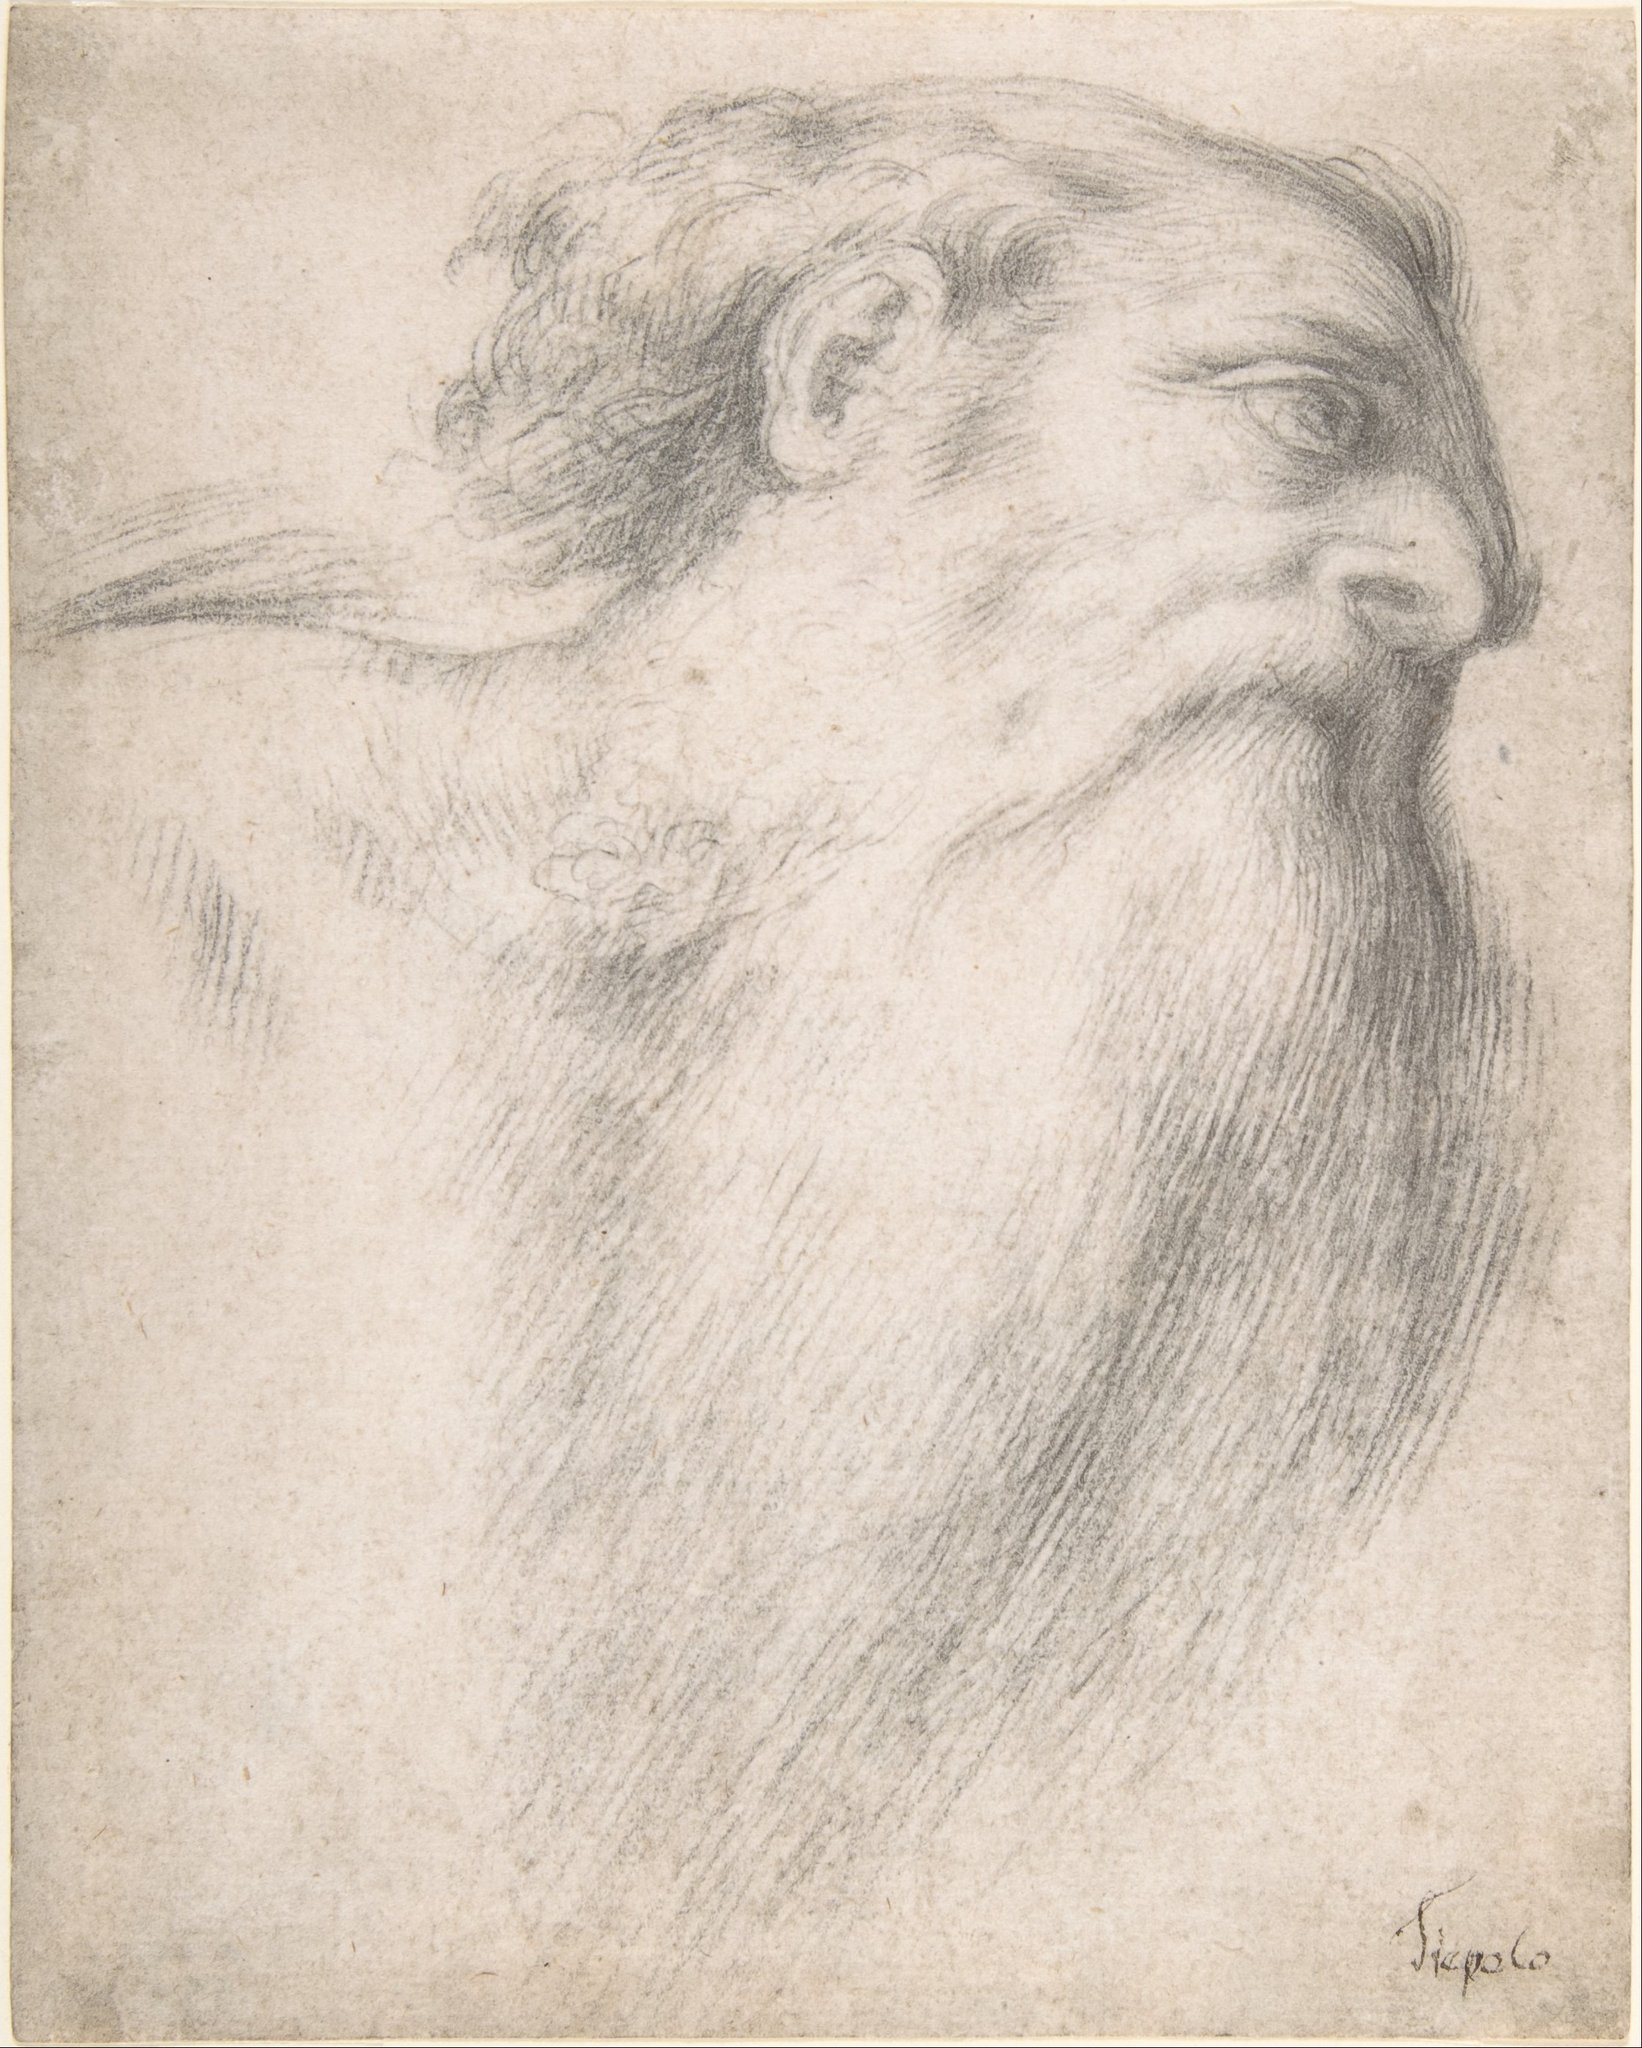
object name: drawing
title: Head of a Bearded Man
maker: lorenzo lotto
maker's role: artist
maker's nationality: italian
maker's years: 1475-1556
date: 1516-1517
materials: chalk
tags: heads,men